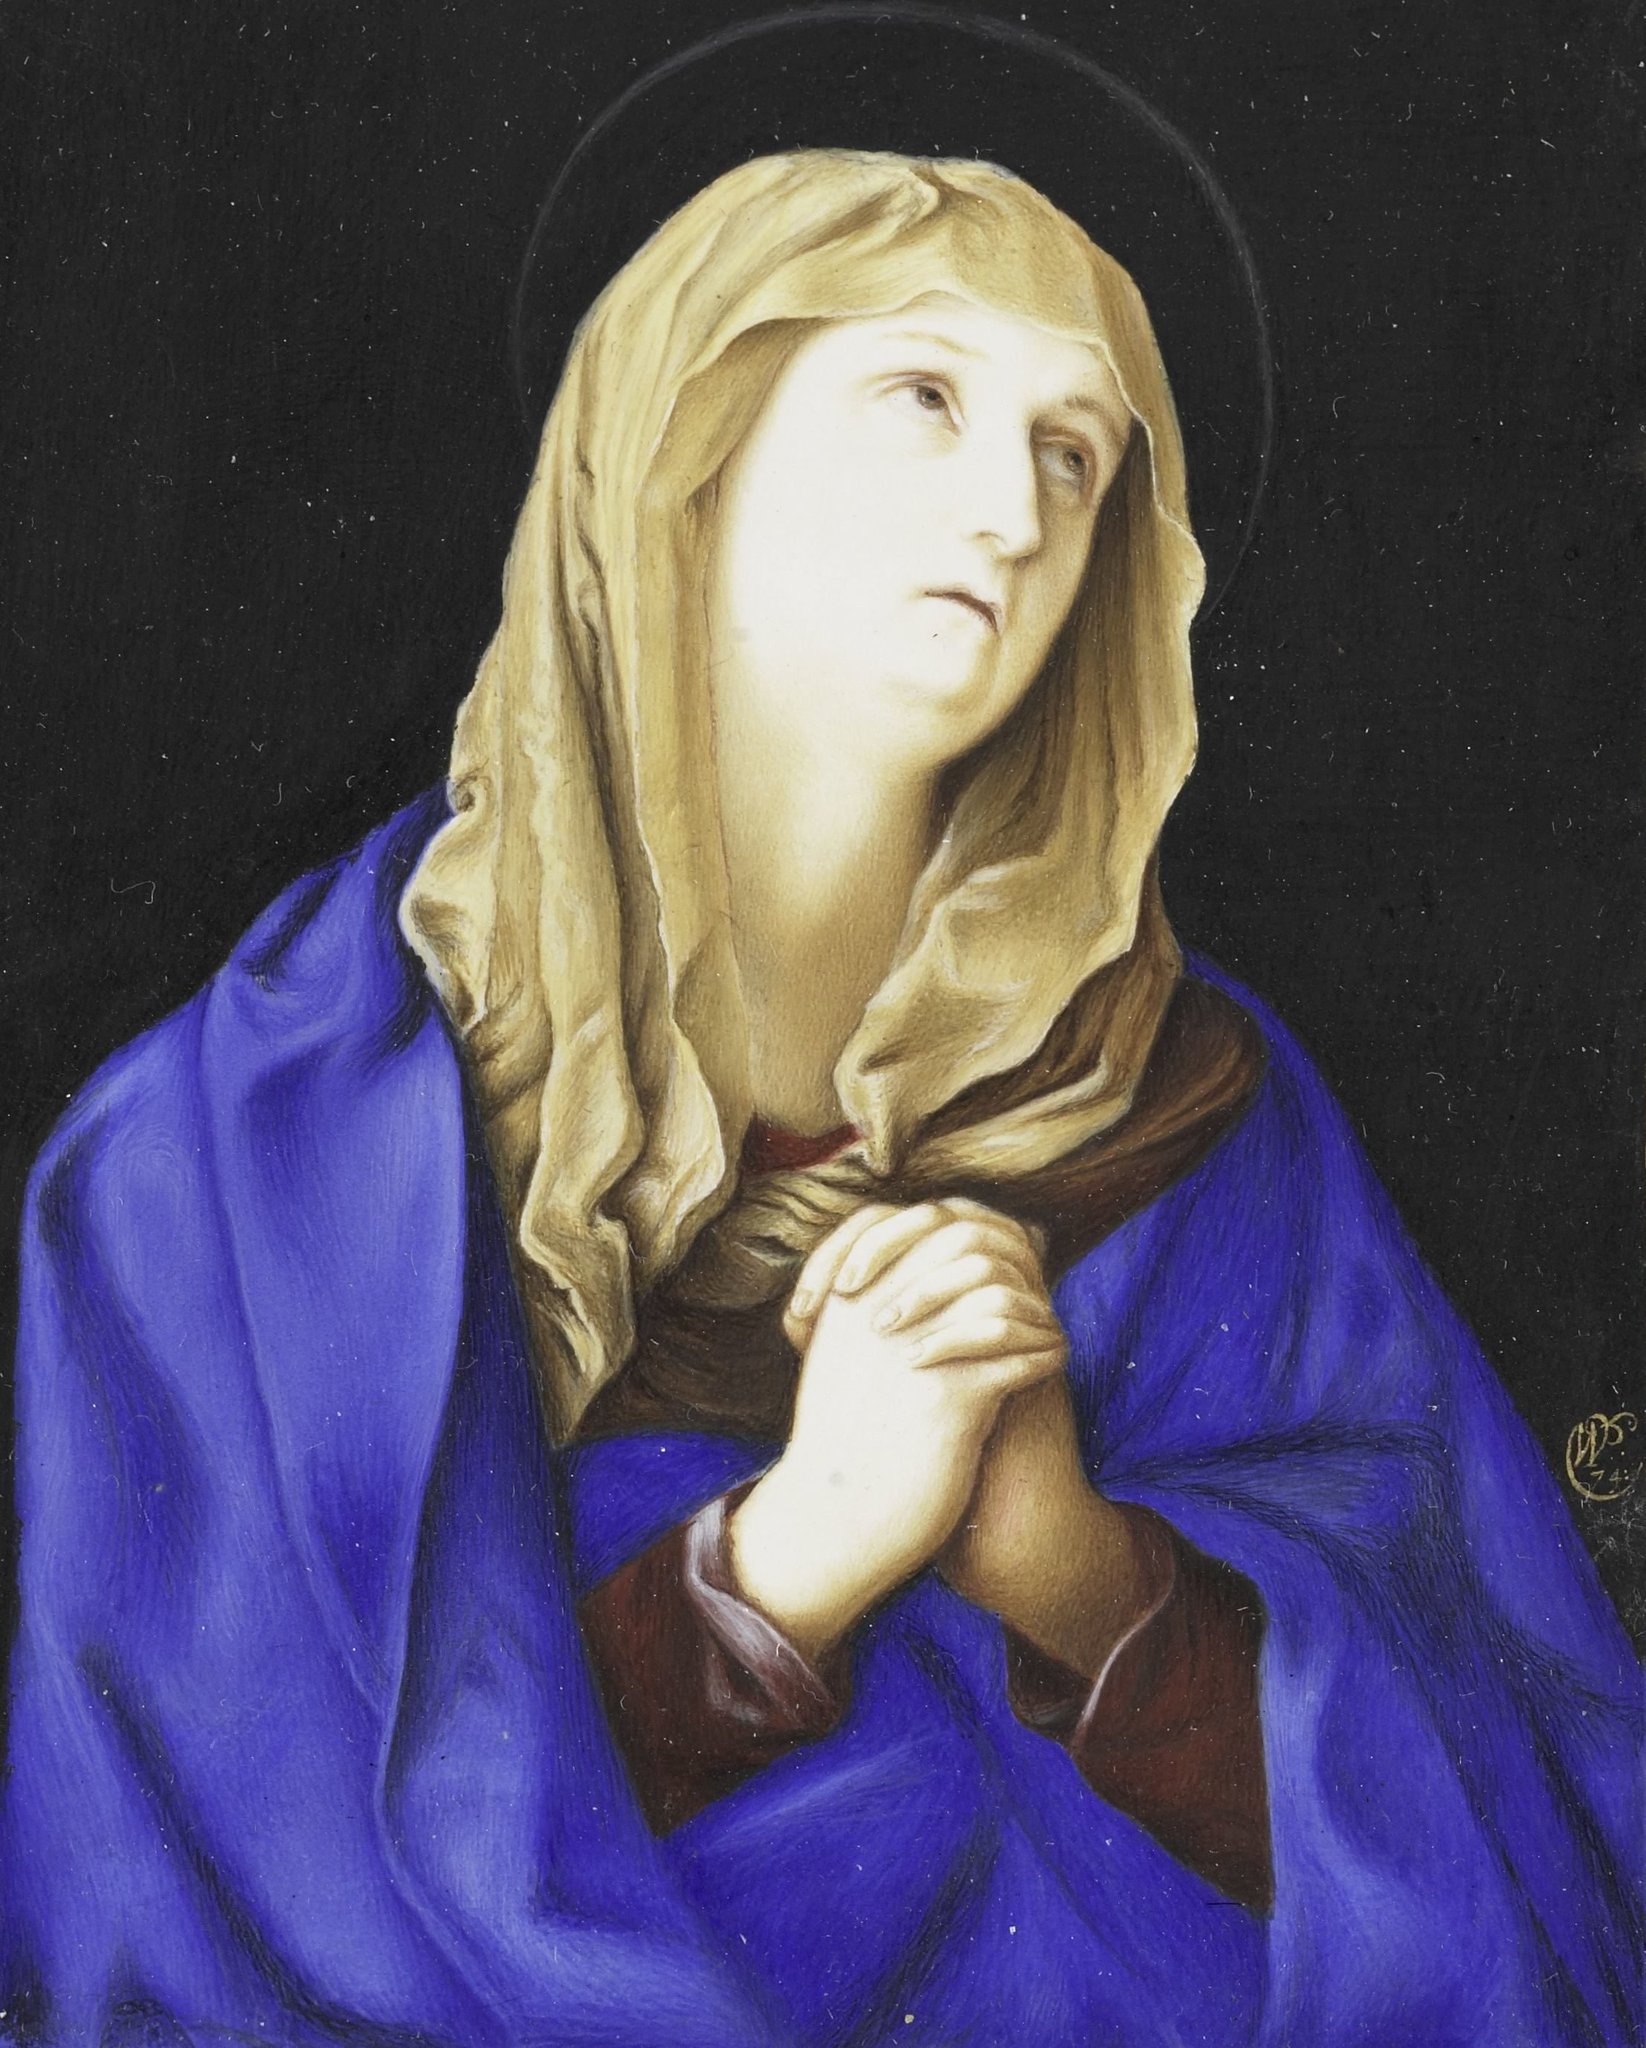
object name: painting, miniature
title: Madonna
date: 1674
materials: cardboard, glass, gouache, oil, tin, wood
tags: 'mater dolorosa'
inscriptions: signature and date: ‘WP 74’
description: Madonna. Halffiguur van Maria, met gevouwen handen, naar rechts opziend. Naar een origineel van Guido Reni.